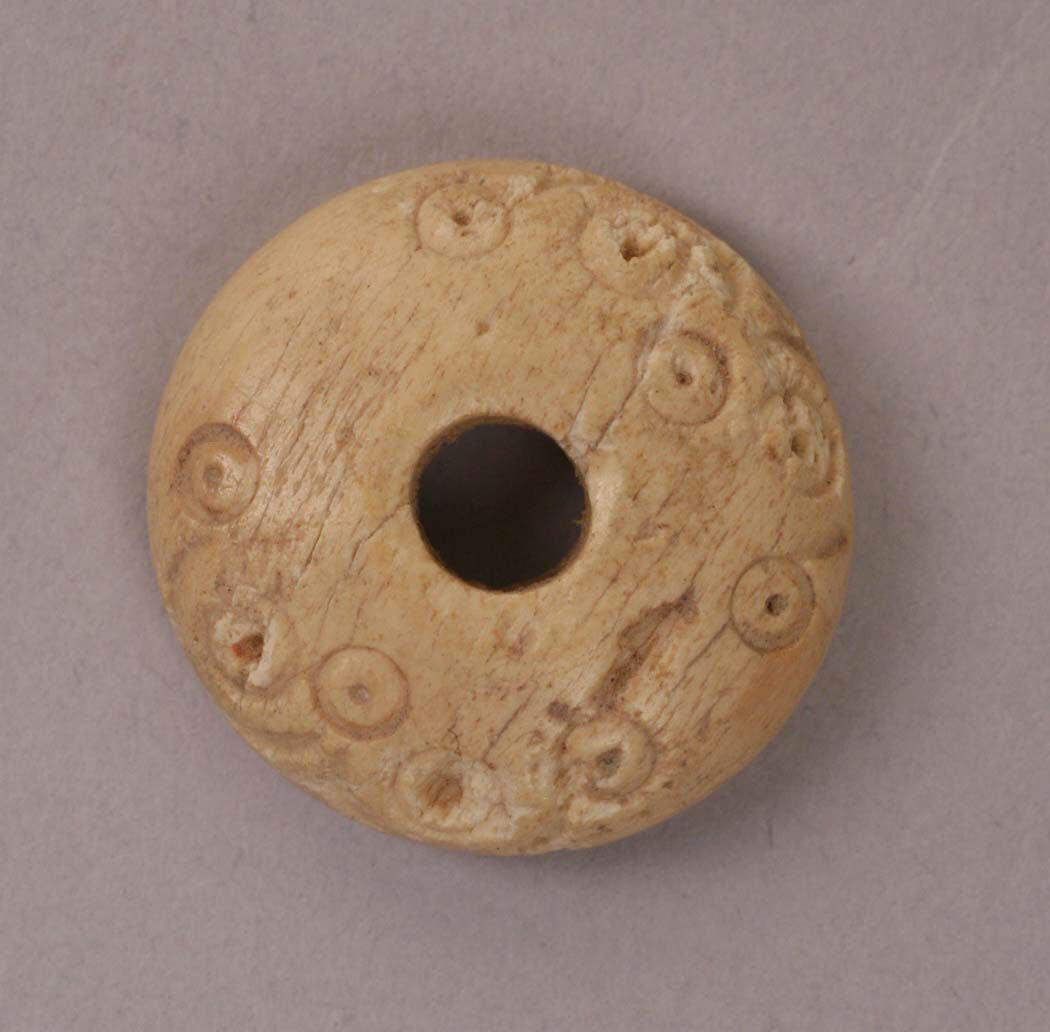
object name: button or bead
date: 801-1000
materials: bone, paint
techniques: incising, inlay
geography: iran